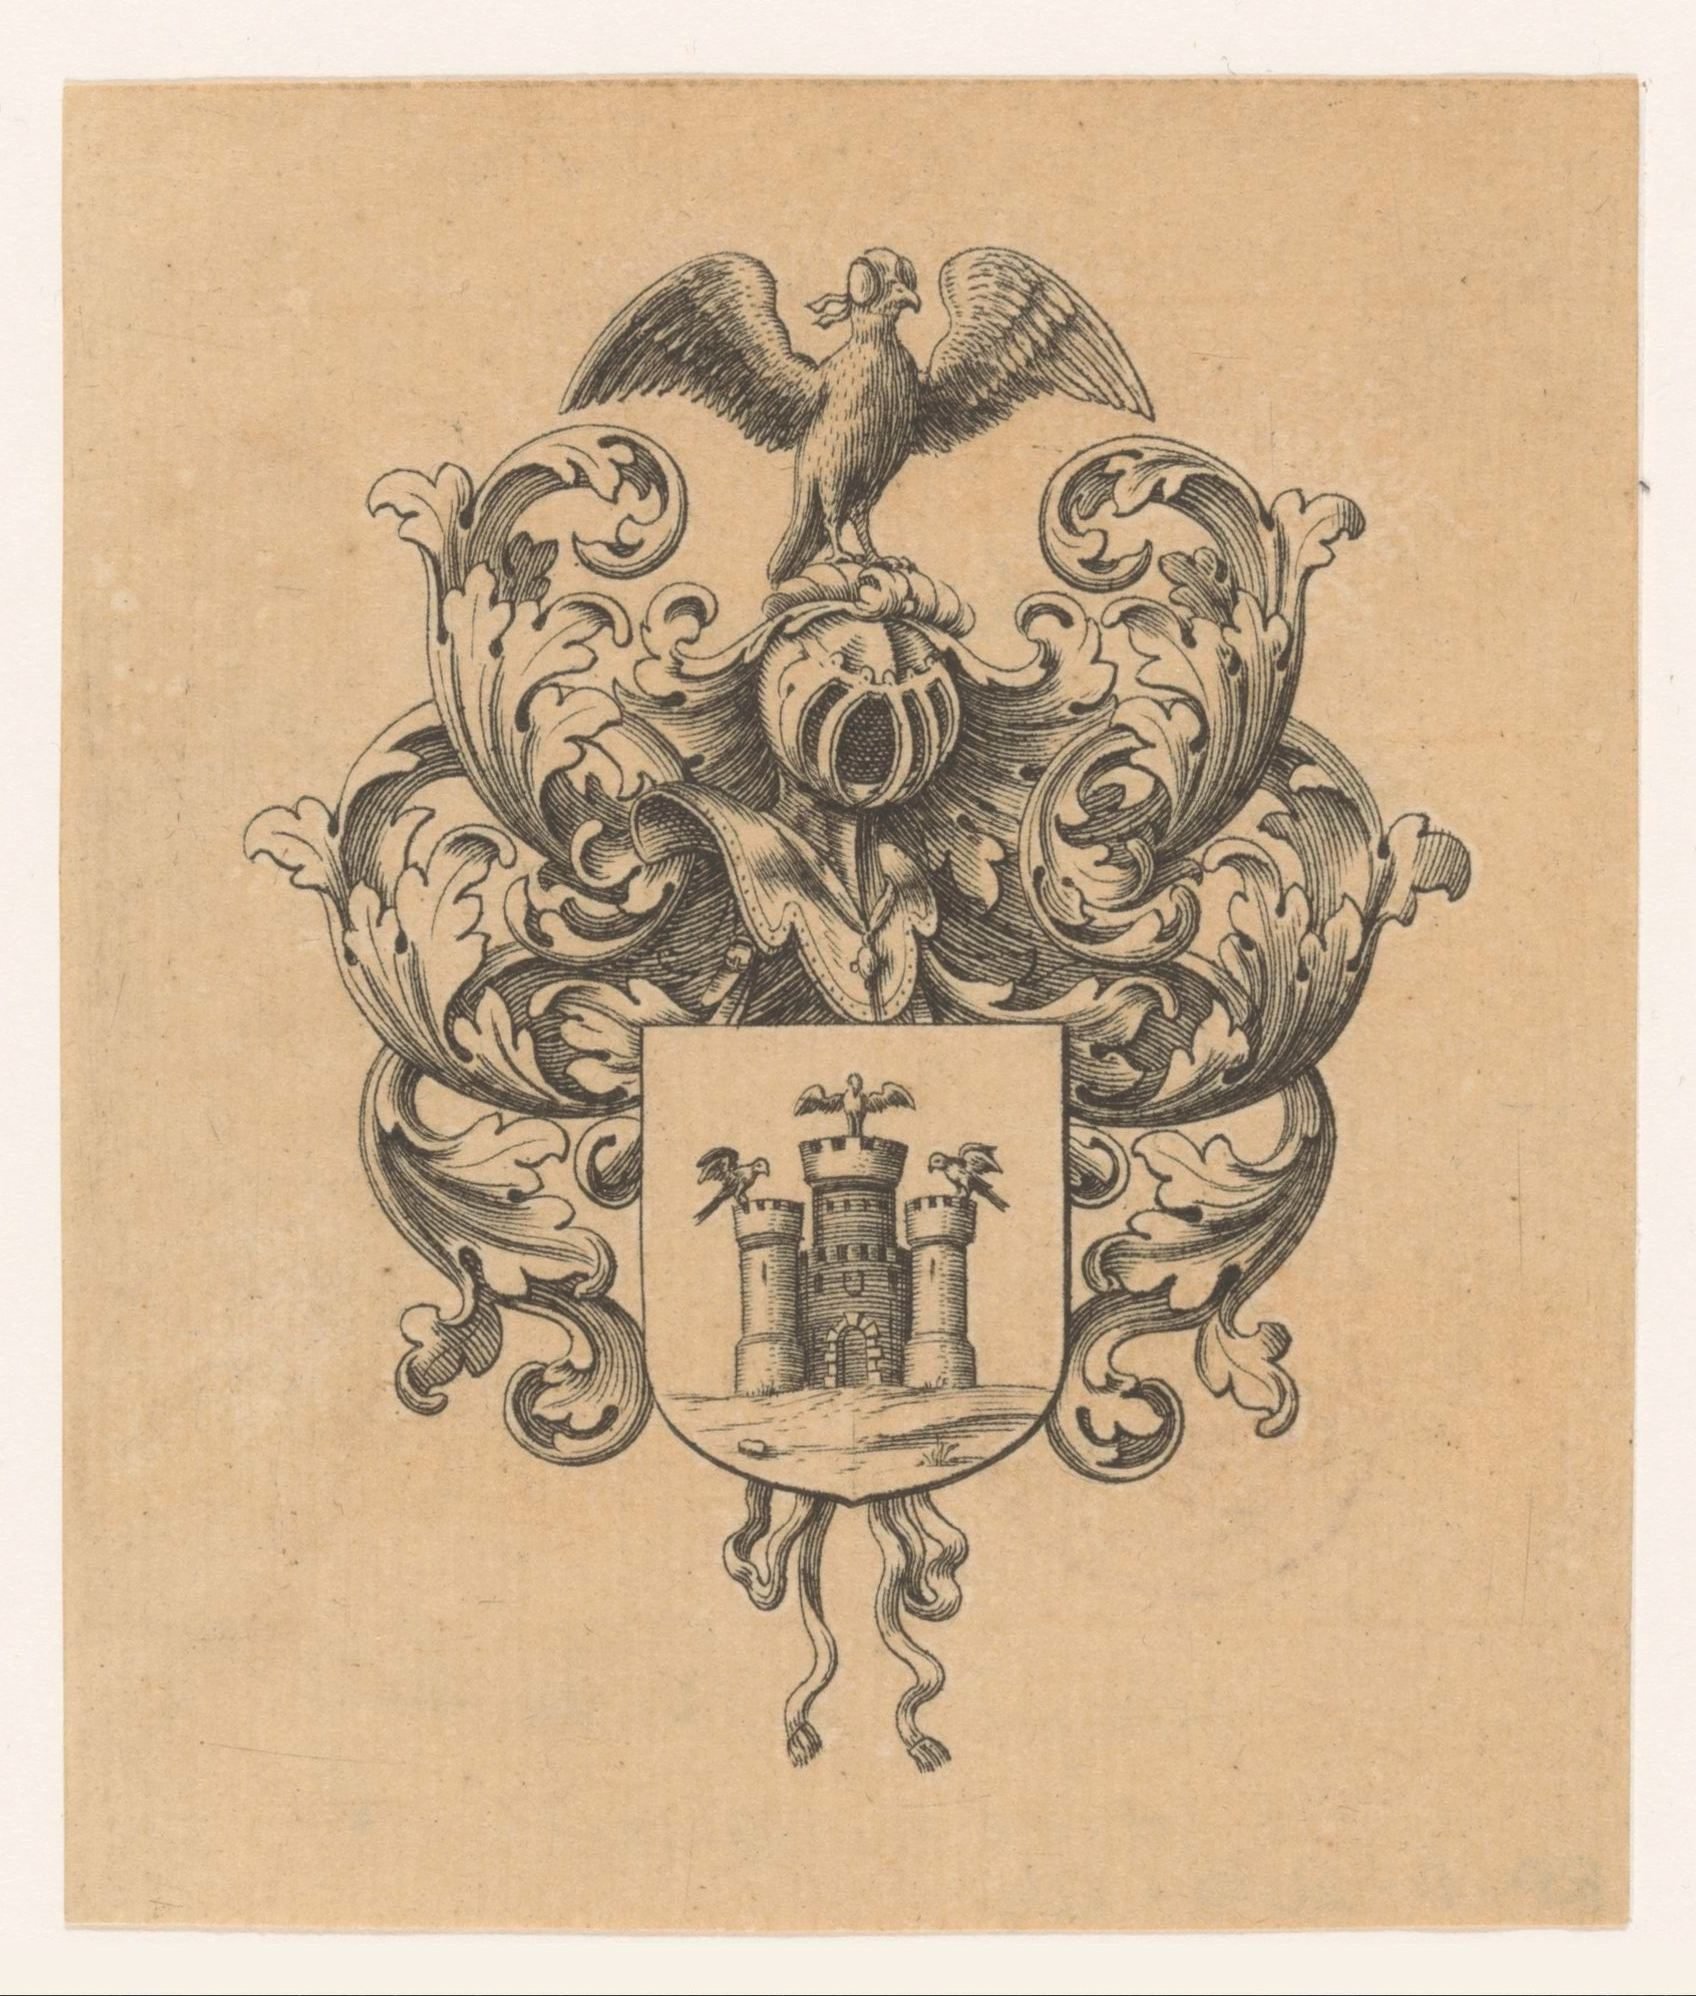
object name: print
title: Wapenschild van Lucas van Valkenburg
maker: michiel le blon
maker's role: print maker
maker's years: 1587-1656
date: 1597-1656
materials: paper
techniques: etching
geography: amsterdam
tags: armorial bearing, heraldry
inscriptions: collector's mark: Lugt 240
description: Wapenschild van Lucas van Valkenburg met aan de bovenzijde een helmteken met valk.